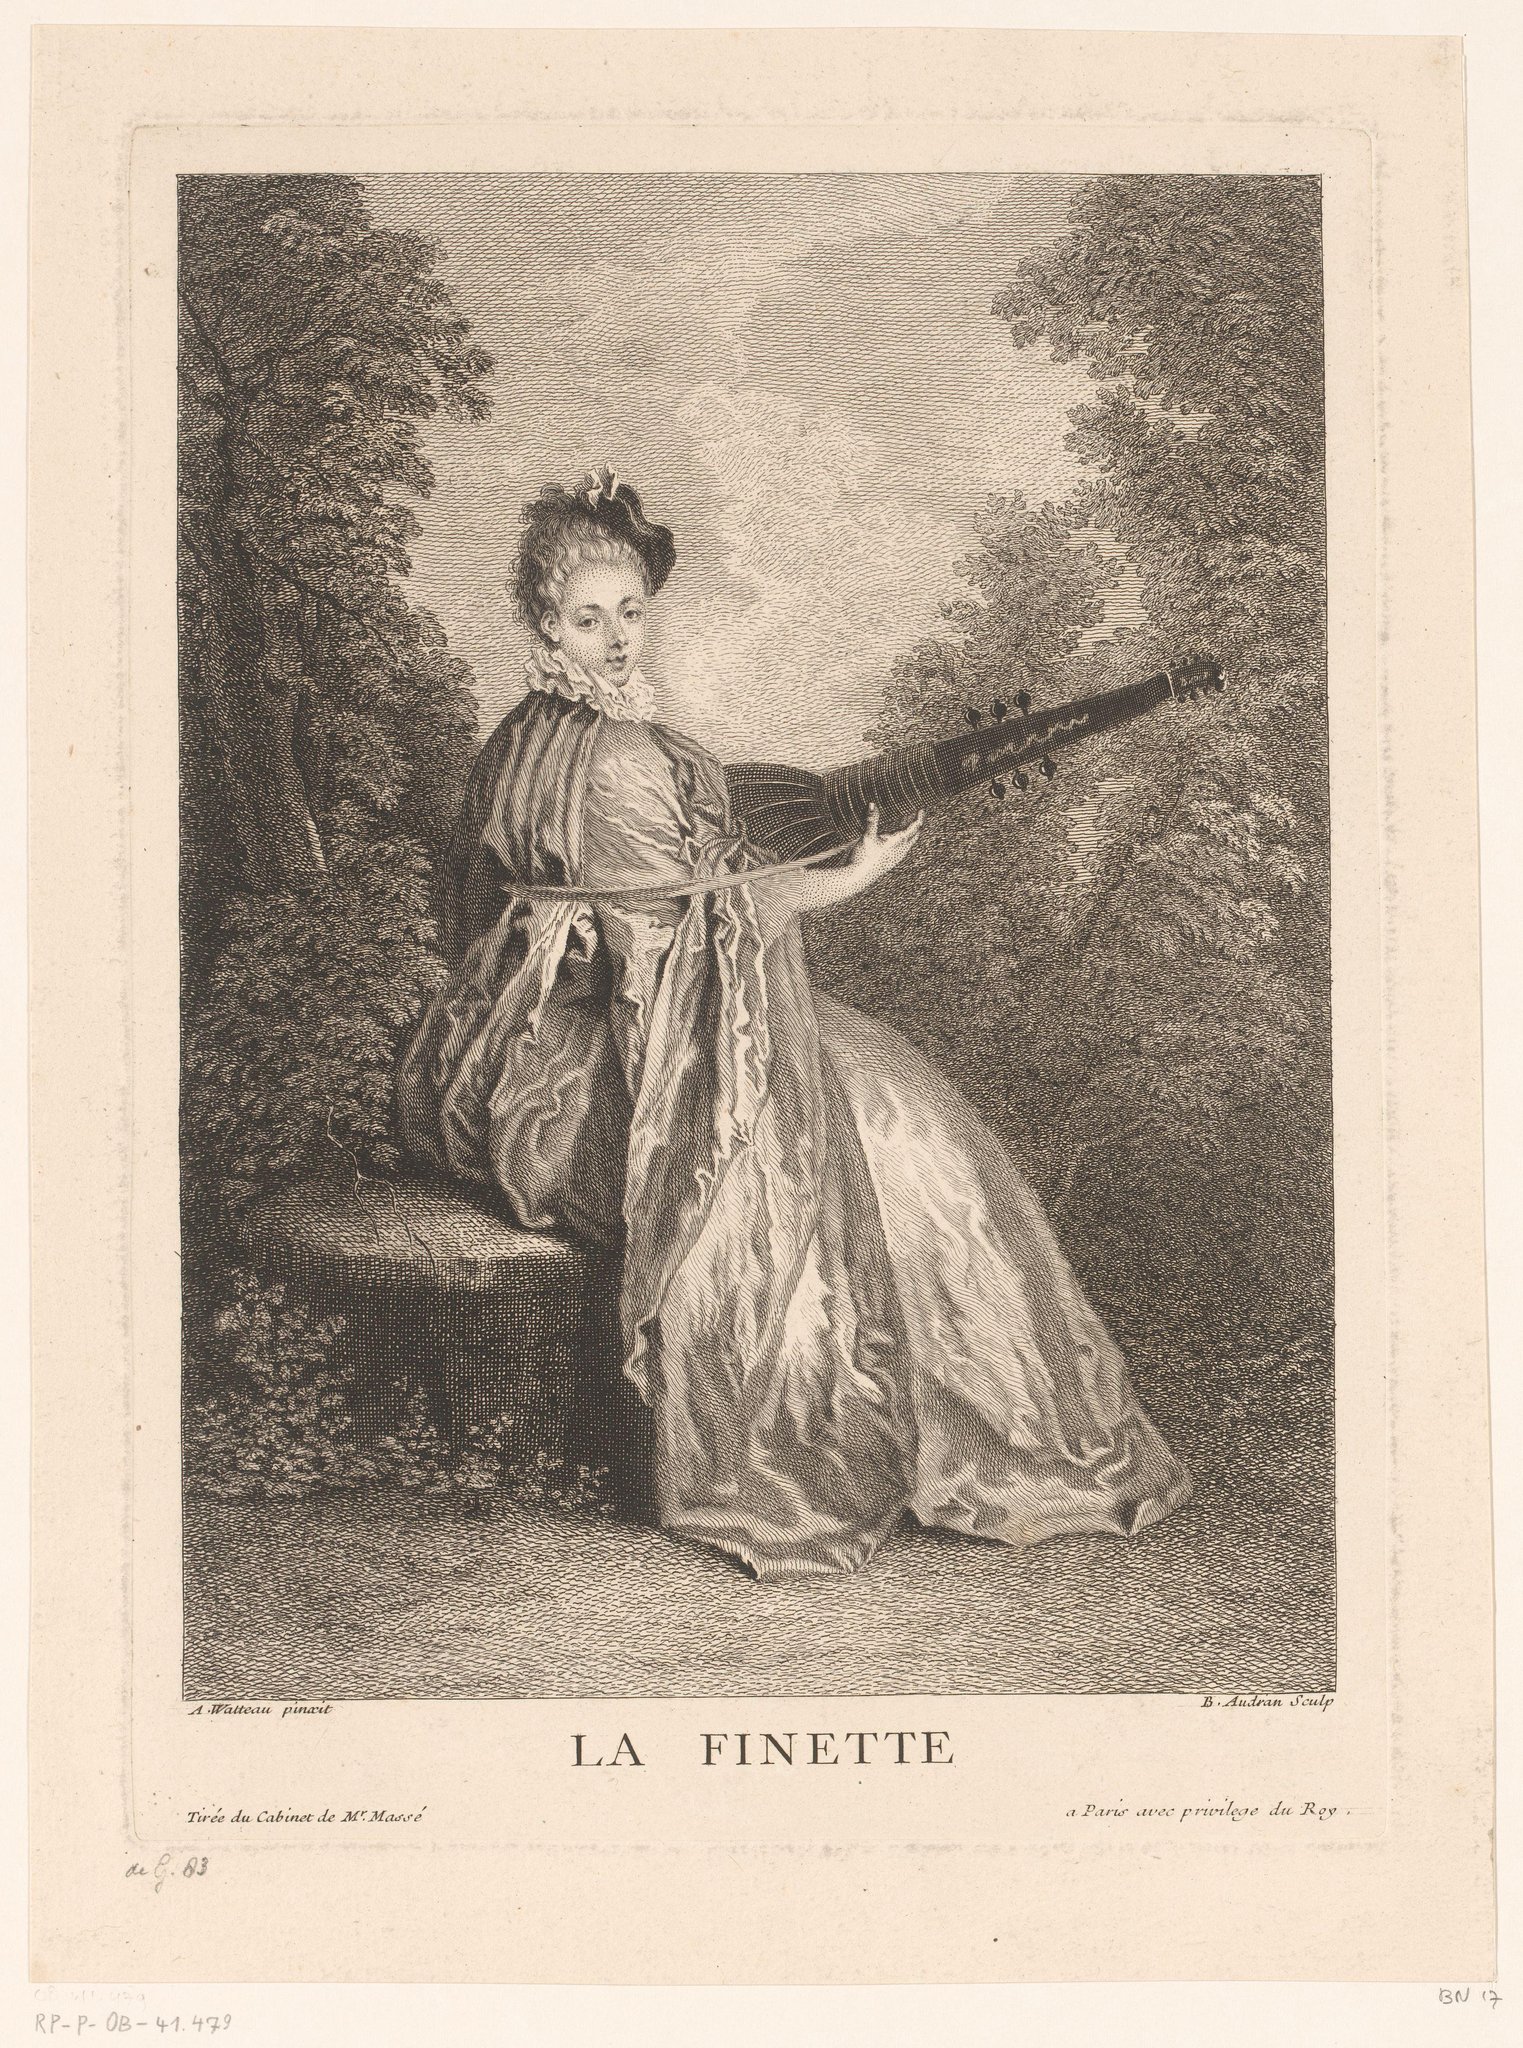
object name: print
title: Portrait of a Theorbo Player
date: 1708-1772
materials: paper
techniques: etching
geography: paris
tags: one person with musical instrument, not playing - cc - out of doors, historical persons, lute, and special forms of lute, e.g.: theorbo - cc - out of doors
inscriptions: collector's mark: Lugt 2228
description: Finette, a stock theatrical character, turns around to look at the viewer while holding a theorbo. Her coy gaze suggests the seductive power of music. Audran made this etching after a painting by Watteau; when printed, the image appears in reverse on paper. As a result, in the print the woman is holding the instrument the wrong way. In the adjacent composition Mezzetino, Watteau presents a more outspoken call for love.